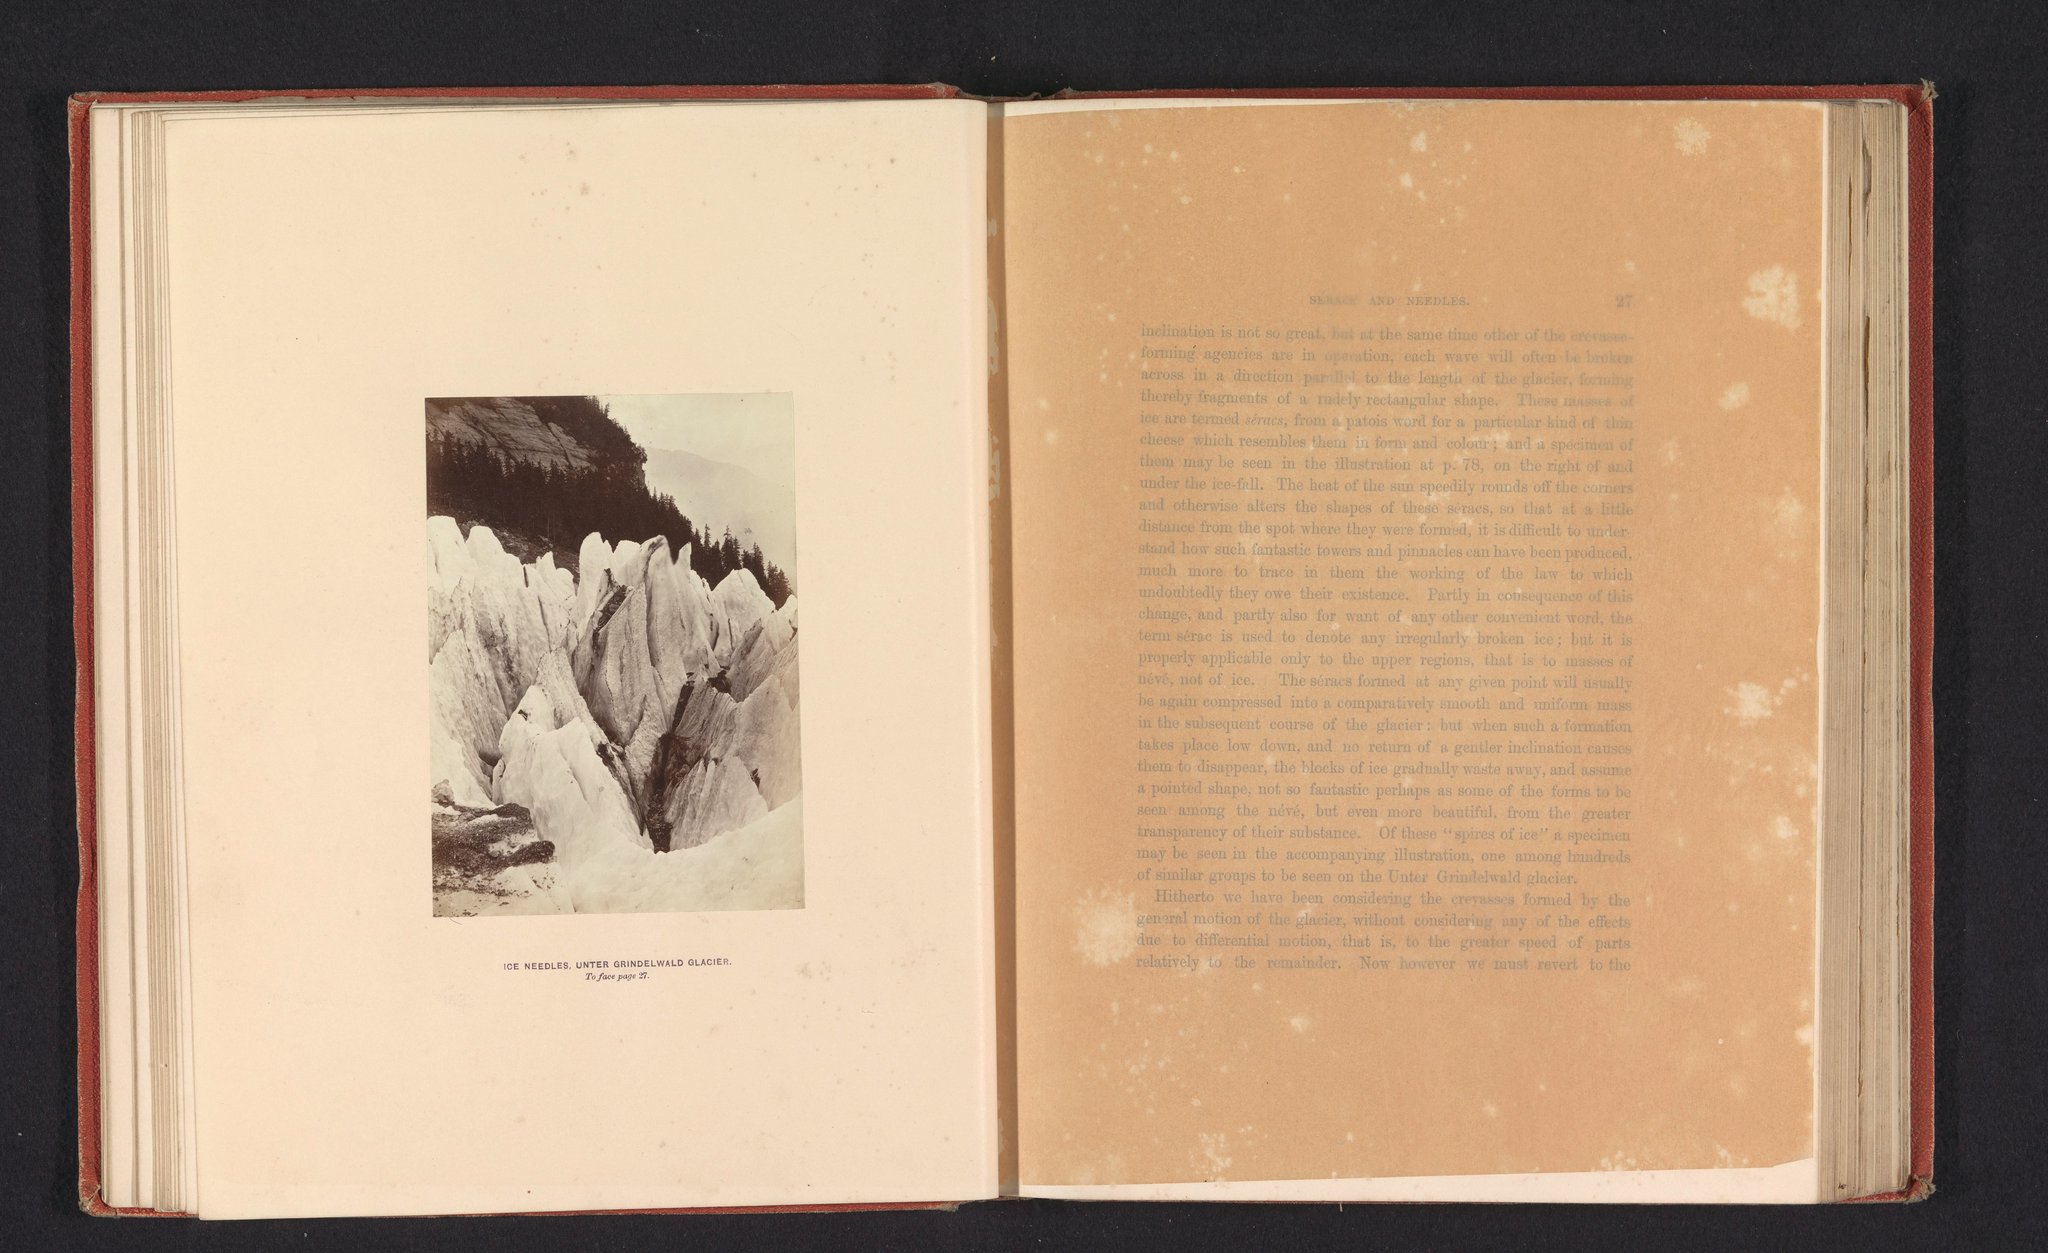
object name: photograph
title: Ice needles, Unter Grindelwald glacier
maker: ernest edwards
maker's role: fotograaf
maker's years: 1837-1903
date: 1850-1866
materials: photographic support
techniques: albumen print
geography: unterer grindelwaldgletsjer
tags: glacier, ice ~ state of water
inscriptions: inscription: ‘To face page 27.’